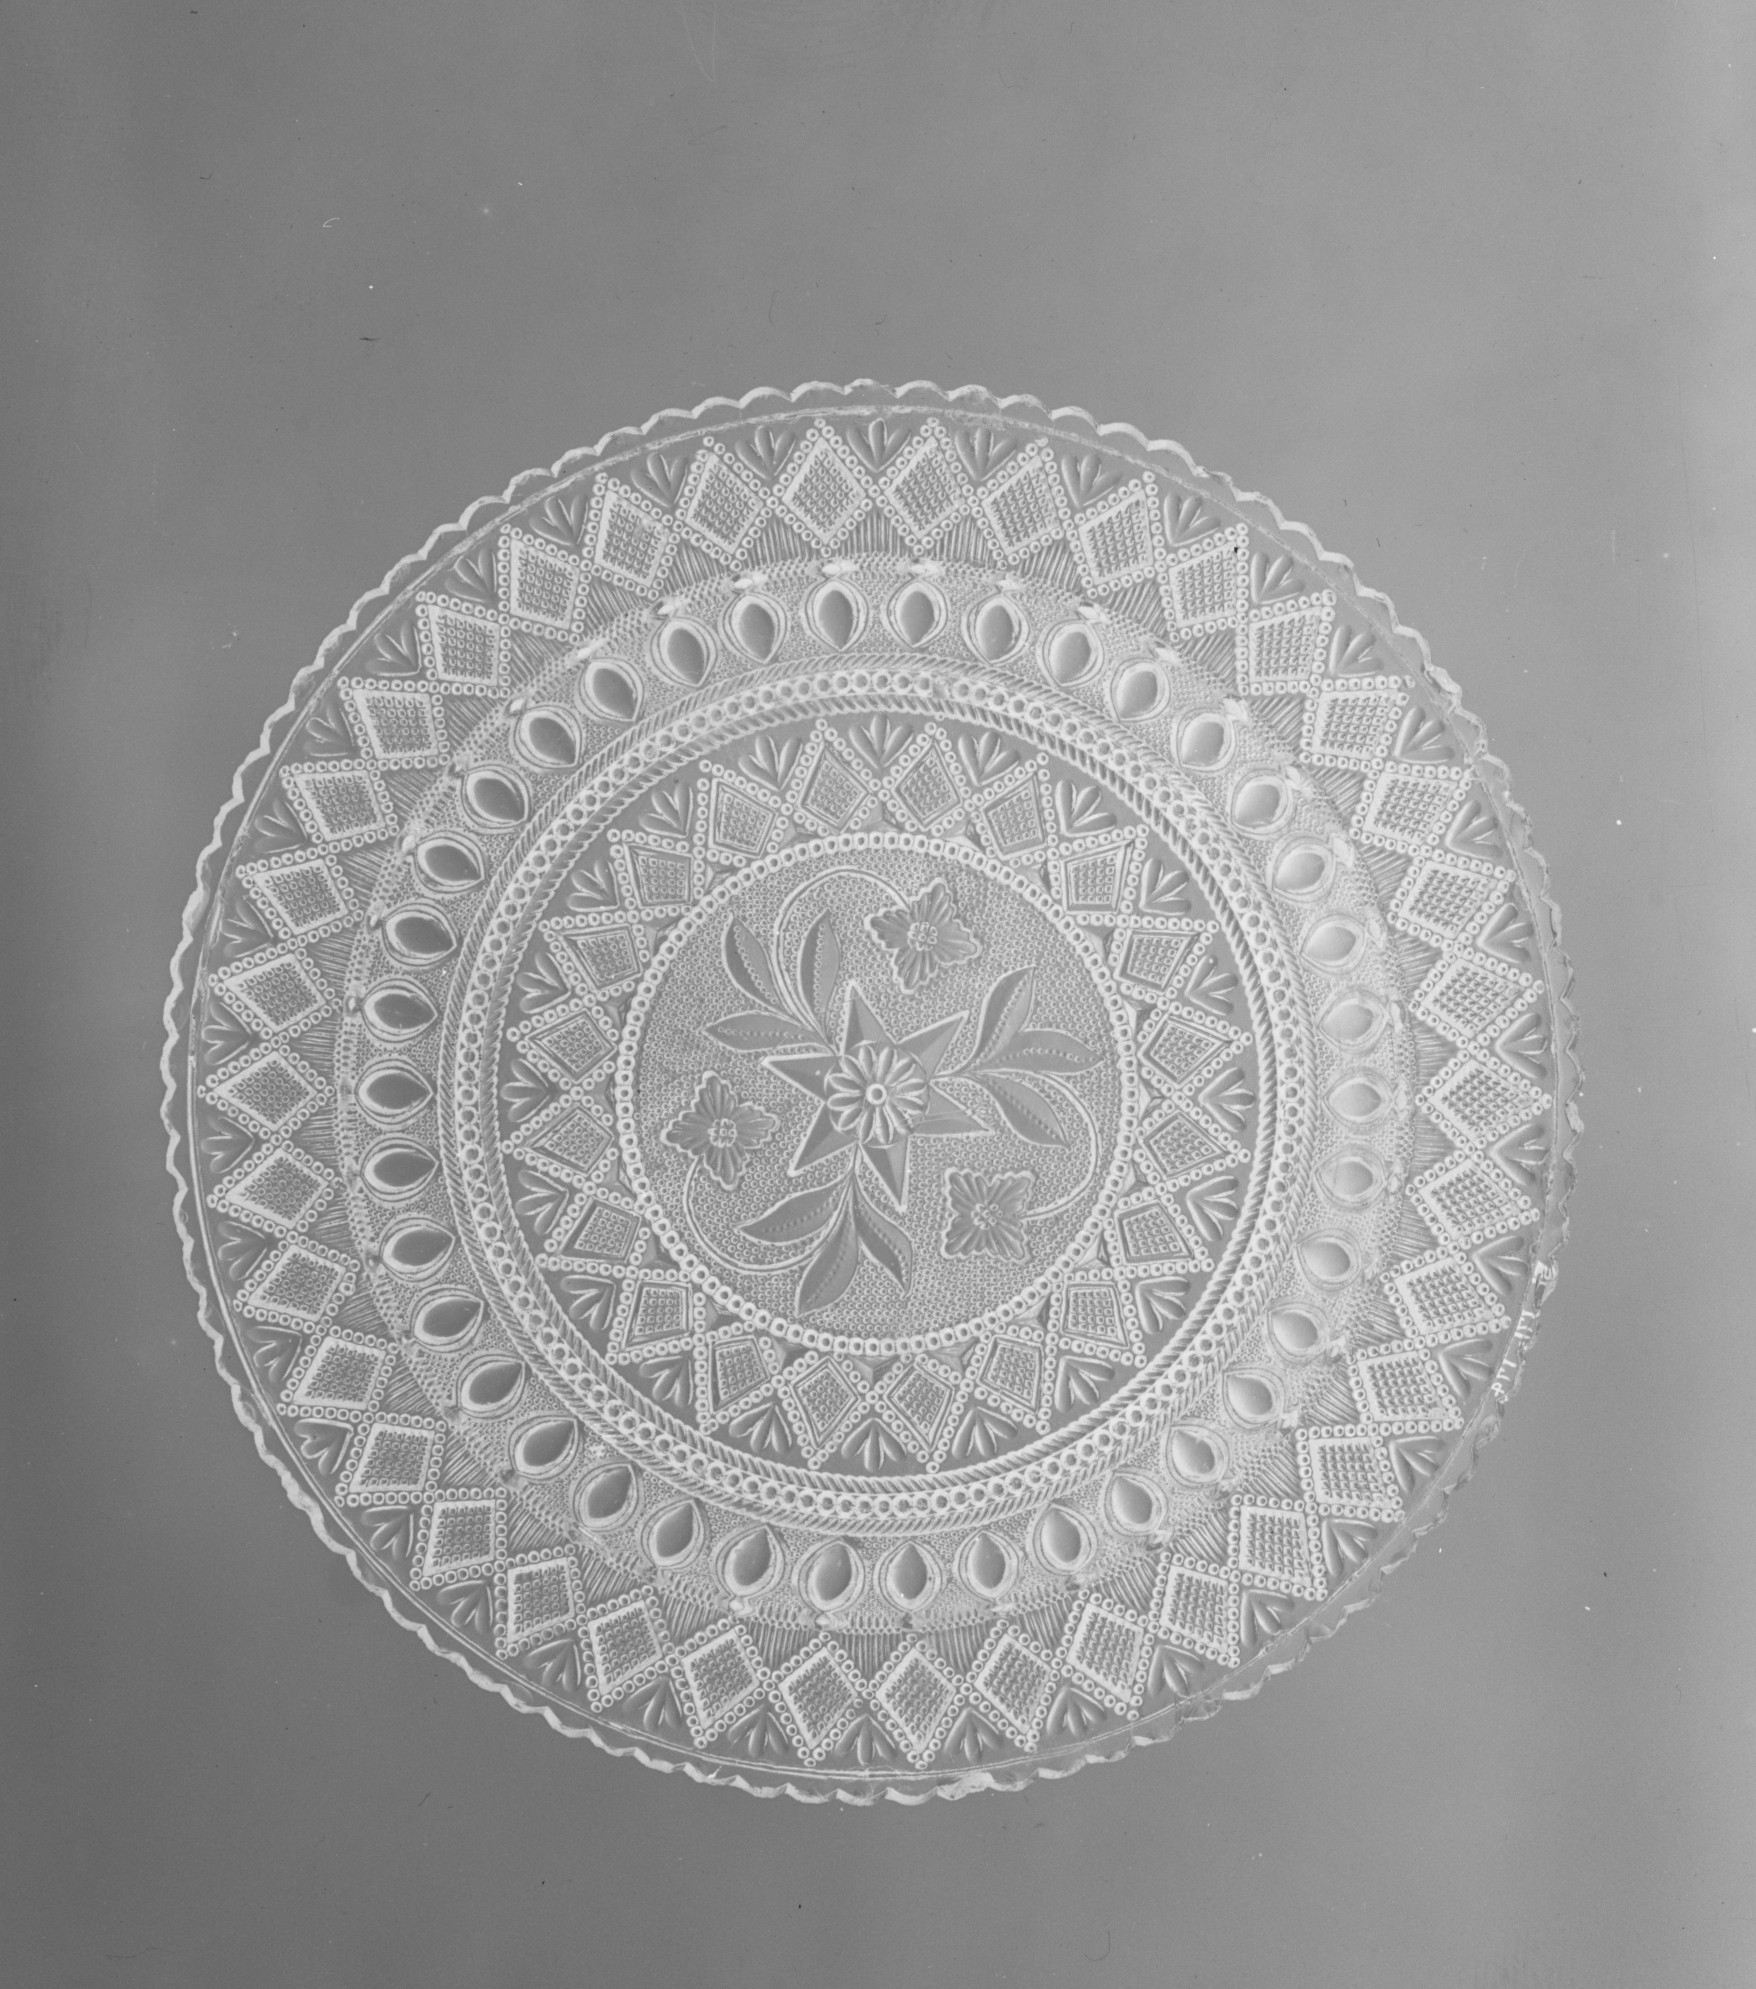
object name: plate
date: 1835-1845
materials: glass